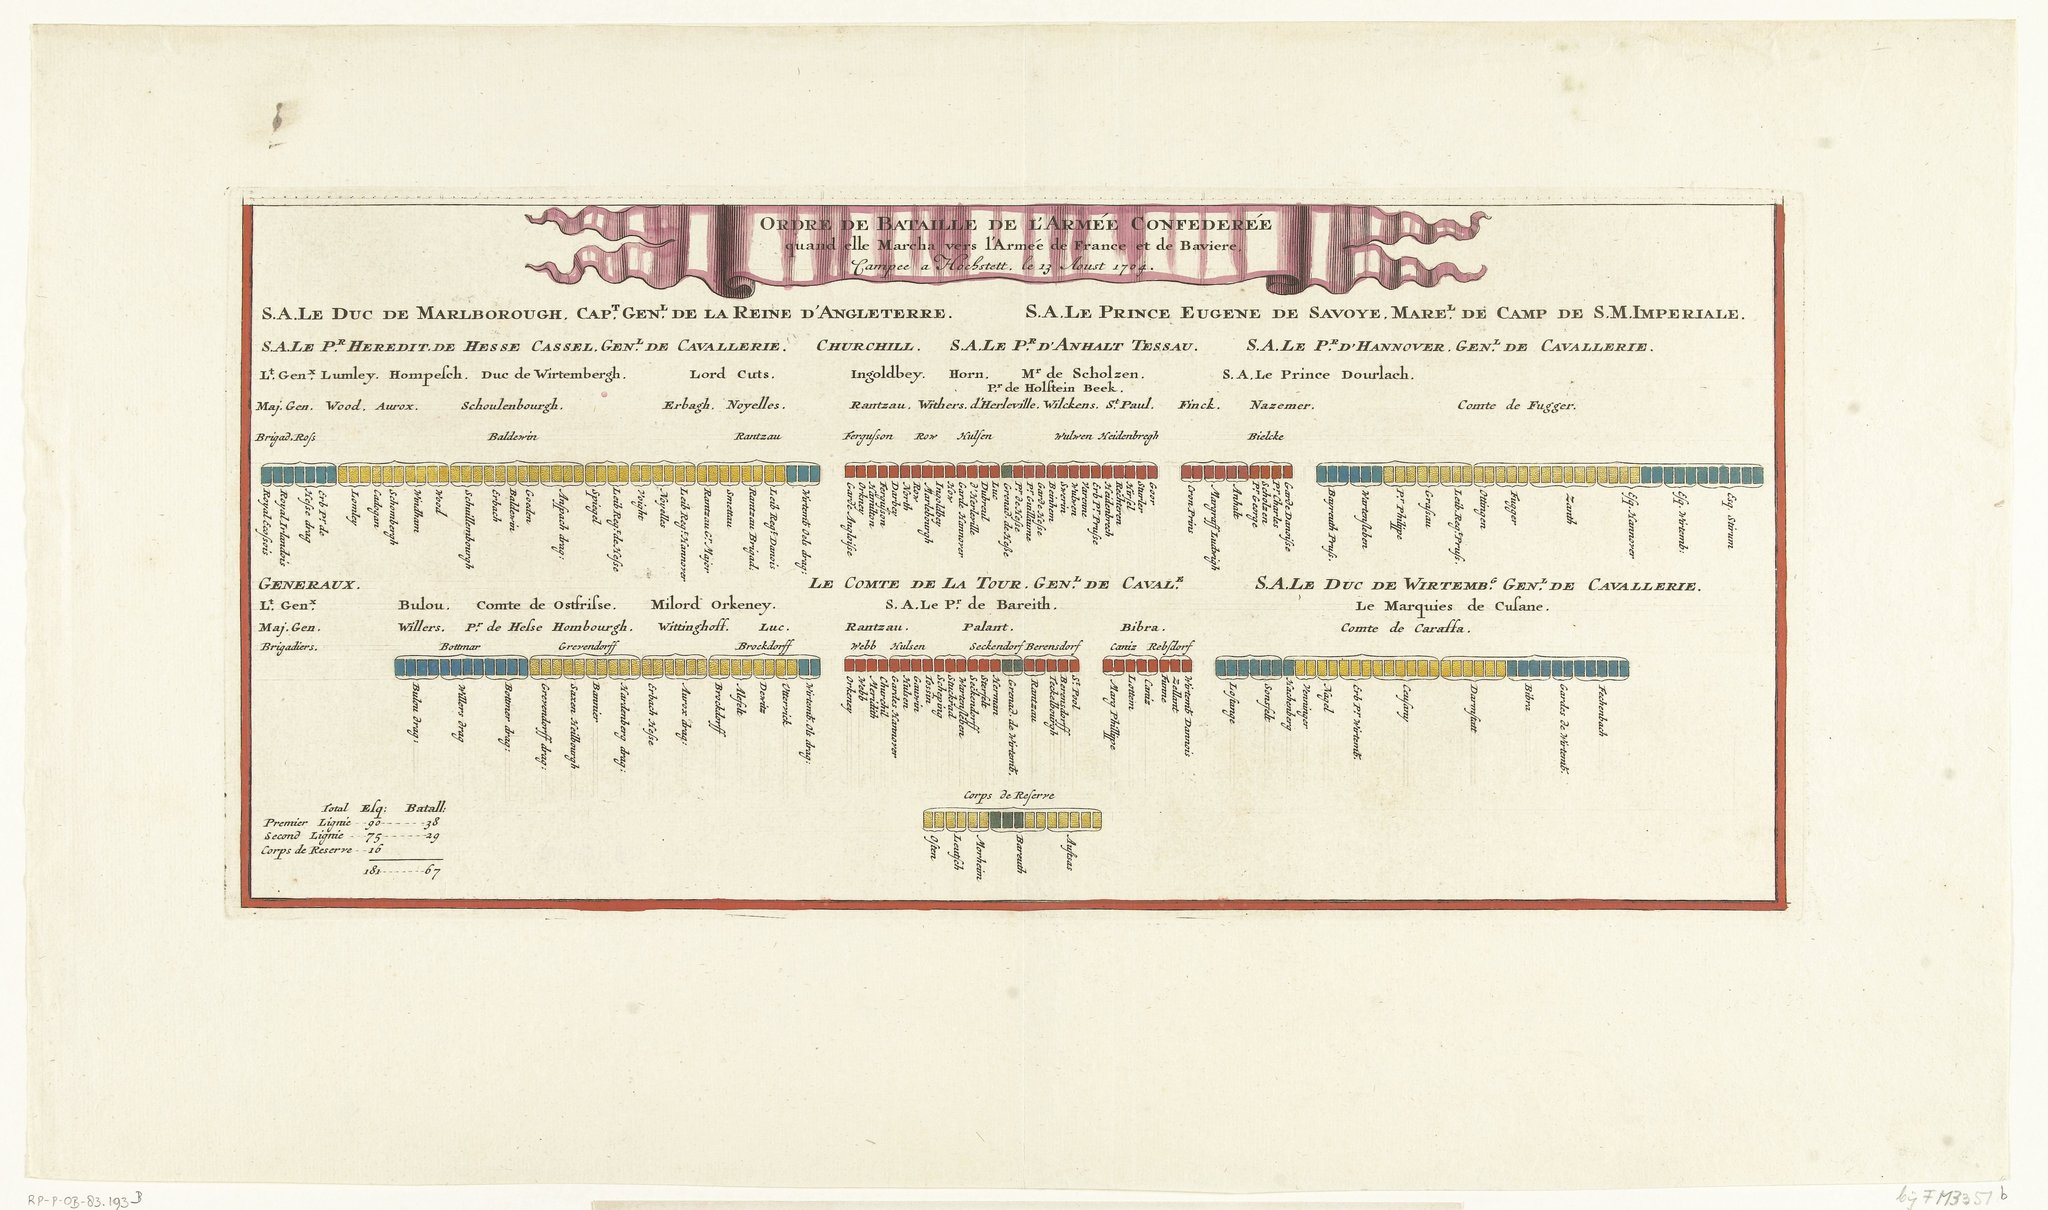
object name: print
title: Slagorde van de Geallieerden voor de slag bij Höchstädt, 1704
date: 1704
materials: paper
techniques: etching, hand coloring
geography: the hague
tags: frederik i (koning van zweden), paris, vienna, eugenius van savoye, john churchill (1e hertog van marlborough), battle arrays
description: Slagorde van de Geallieerden voor de slag bij Höchstädt (slag bij Blenheim) tegen de Fransen, 13 augustus 1704. Behoort bij de kaart van de veldslag.